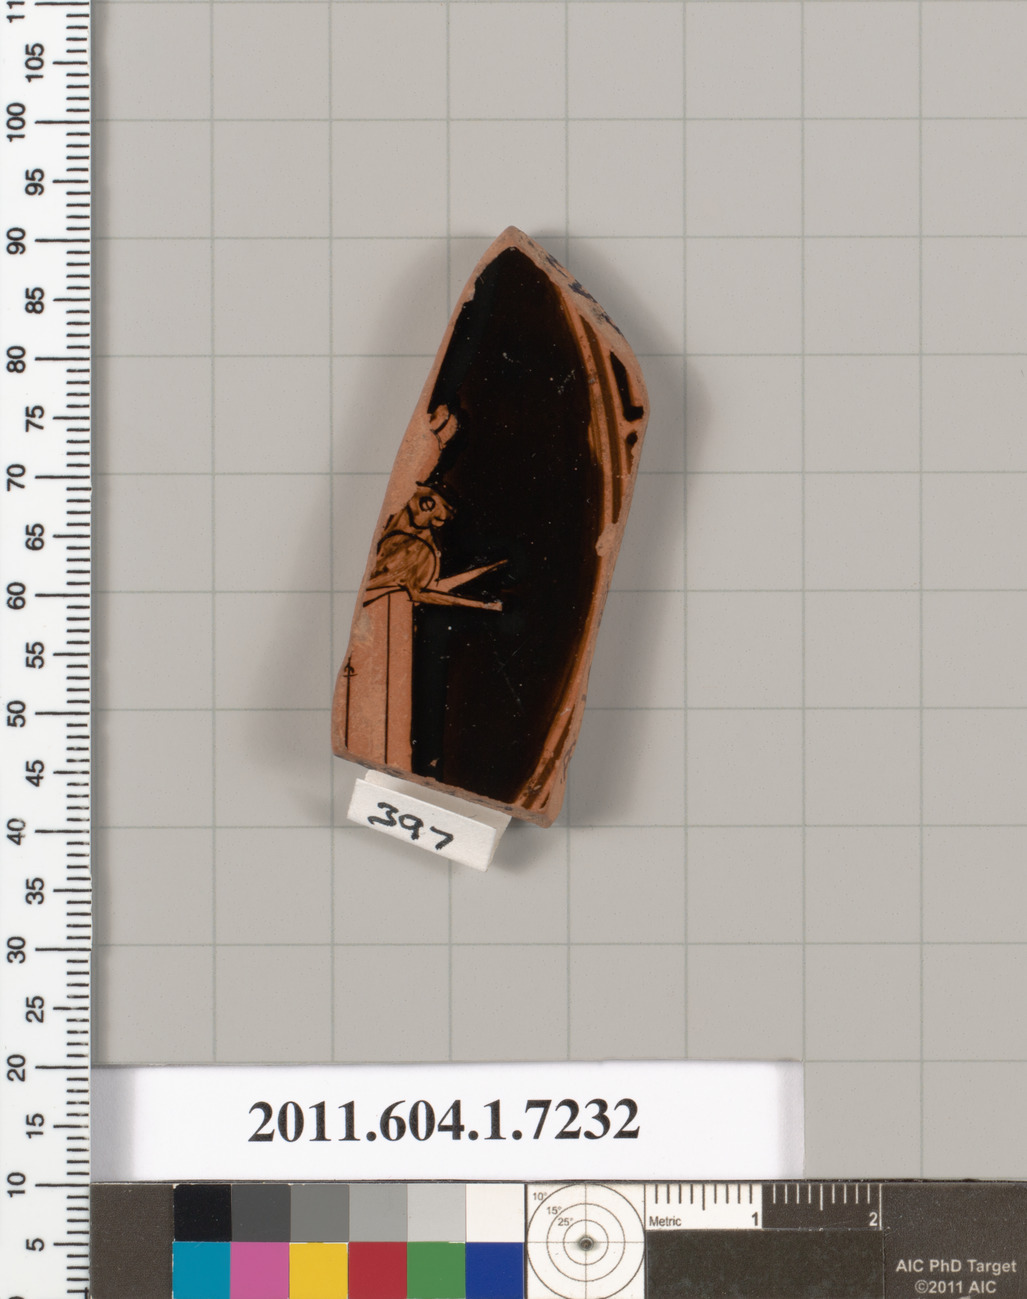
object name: kylix fragment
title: Terracotta fragment of a kylix (drinking cup)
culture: greek, attic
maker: makron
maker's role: artist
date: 500-480 BCE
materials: terracotta